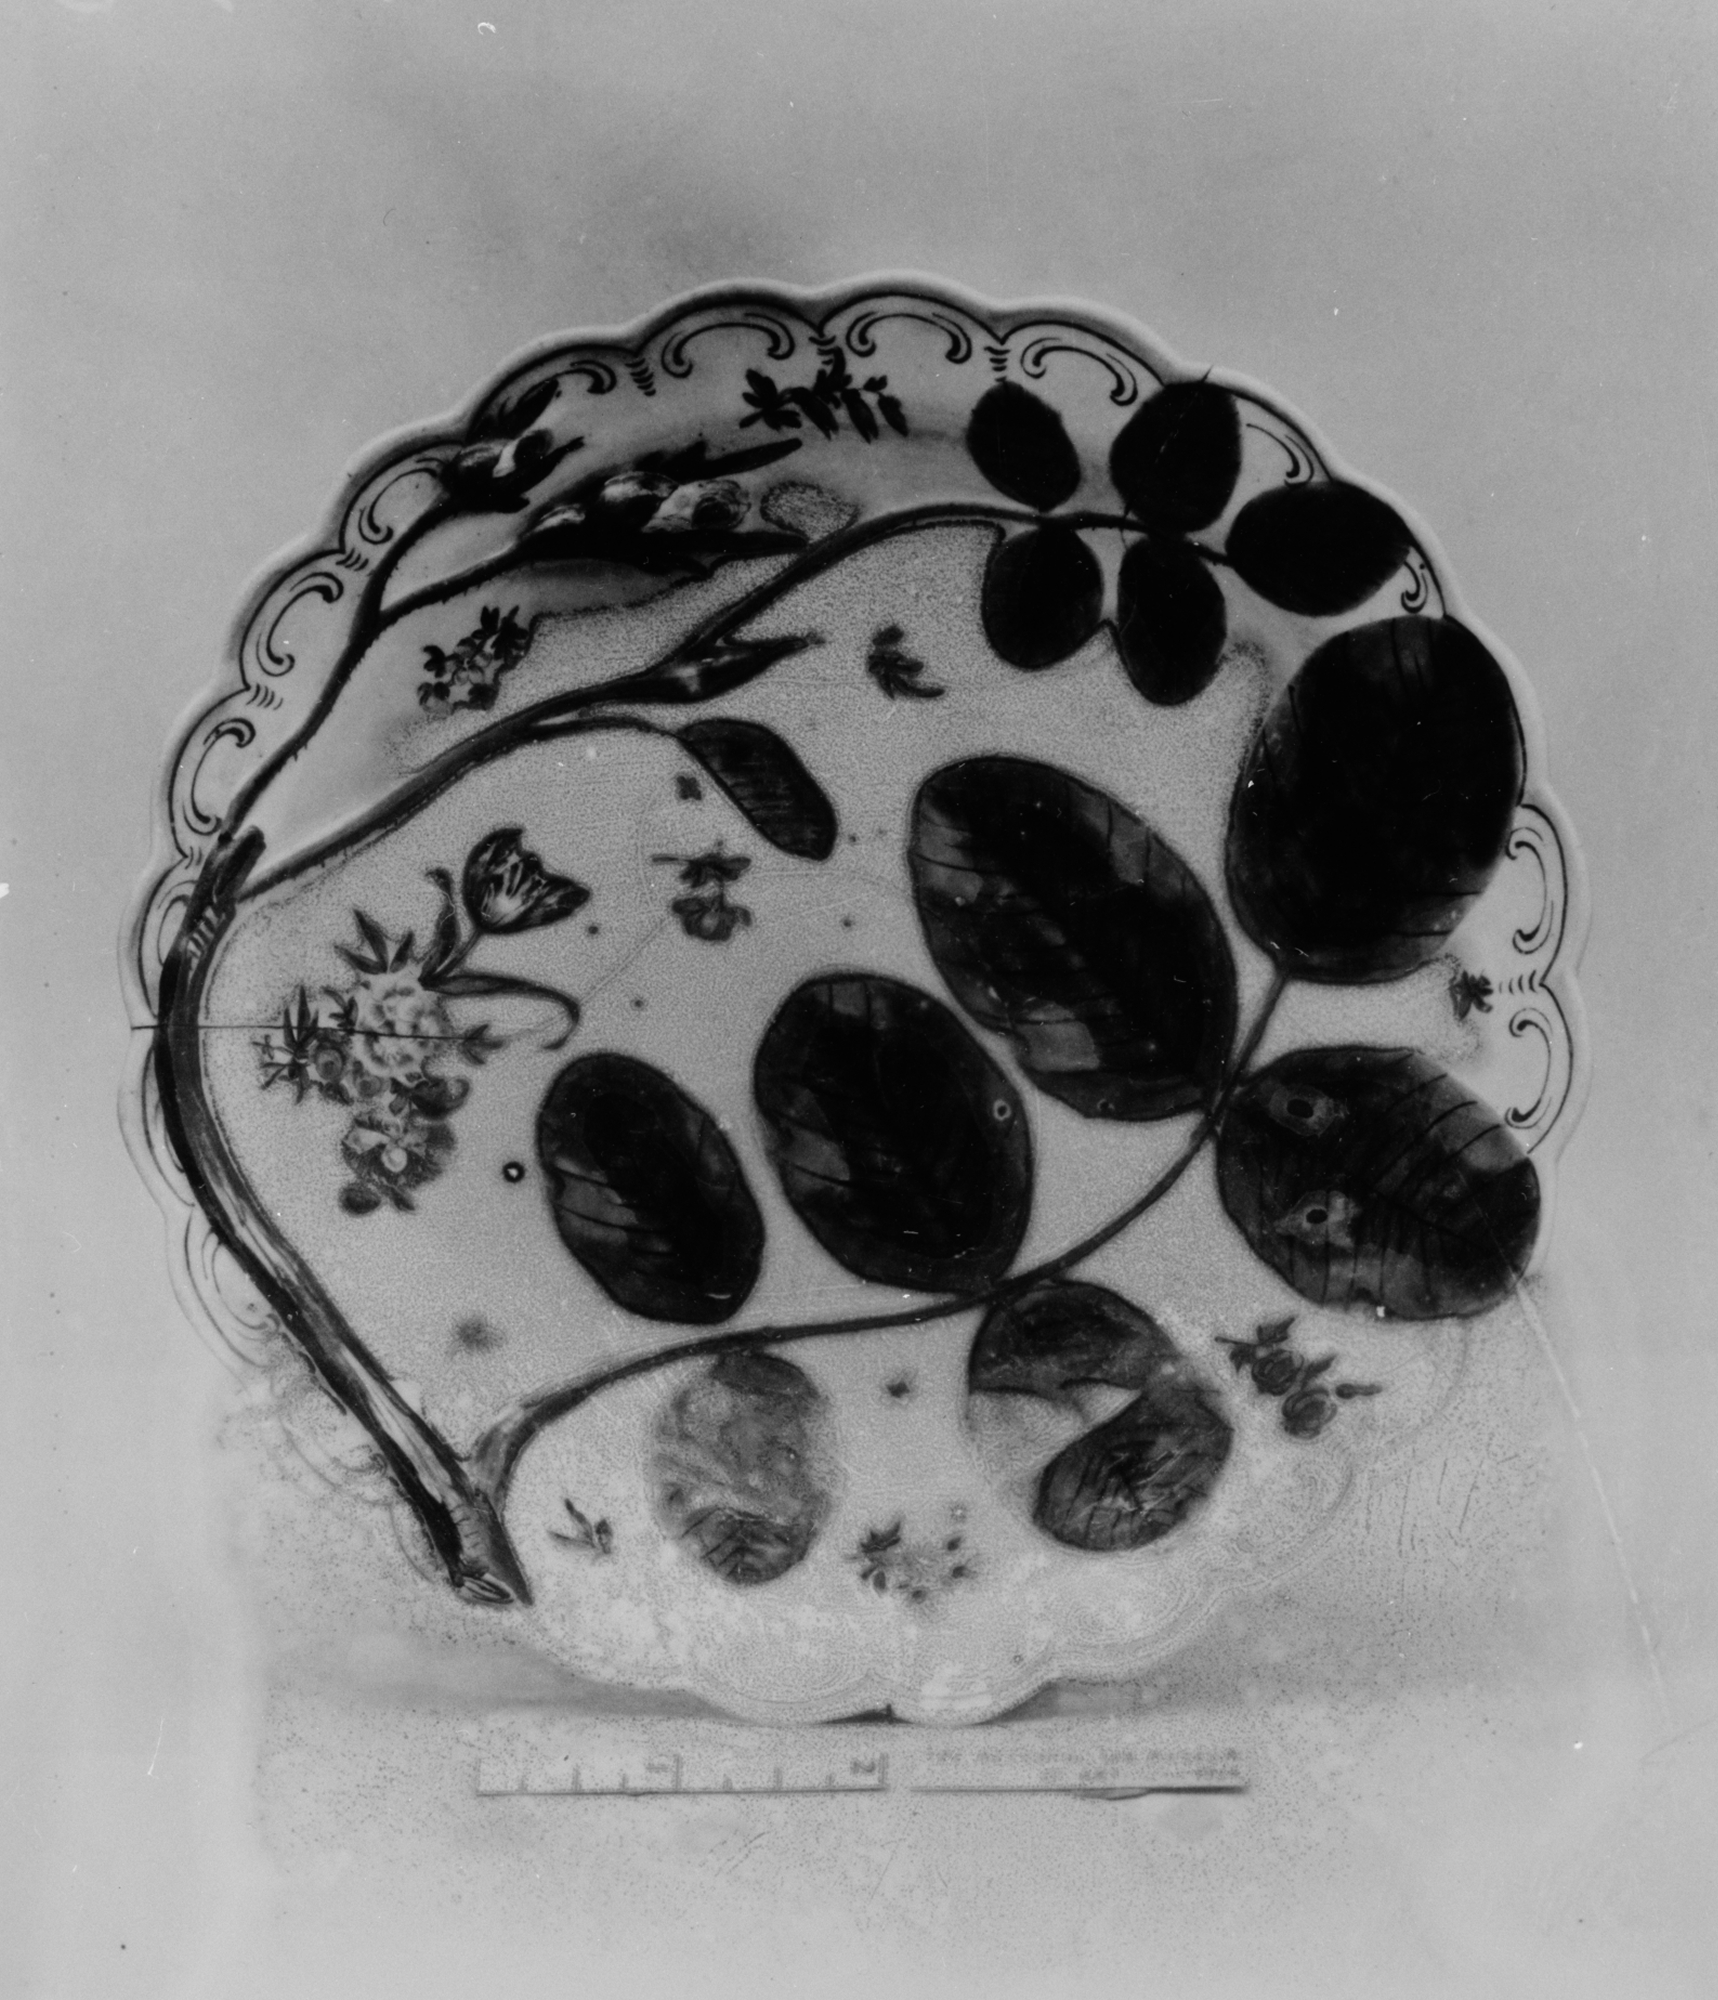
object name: plate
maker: worcester factory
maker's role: factory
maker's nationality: british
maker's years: 1751-2008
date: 1751-1783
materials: soft paste porcelain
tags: leaves